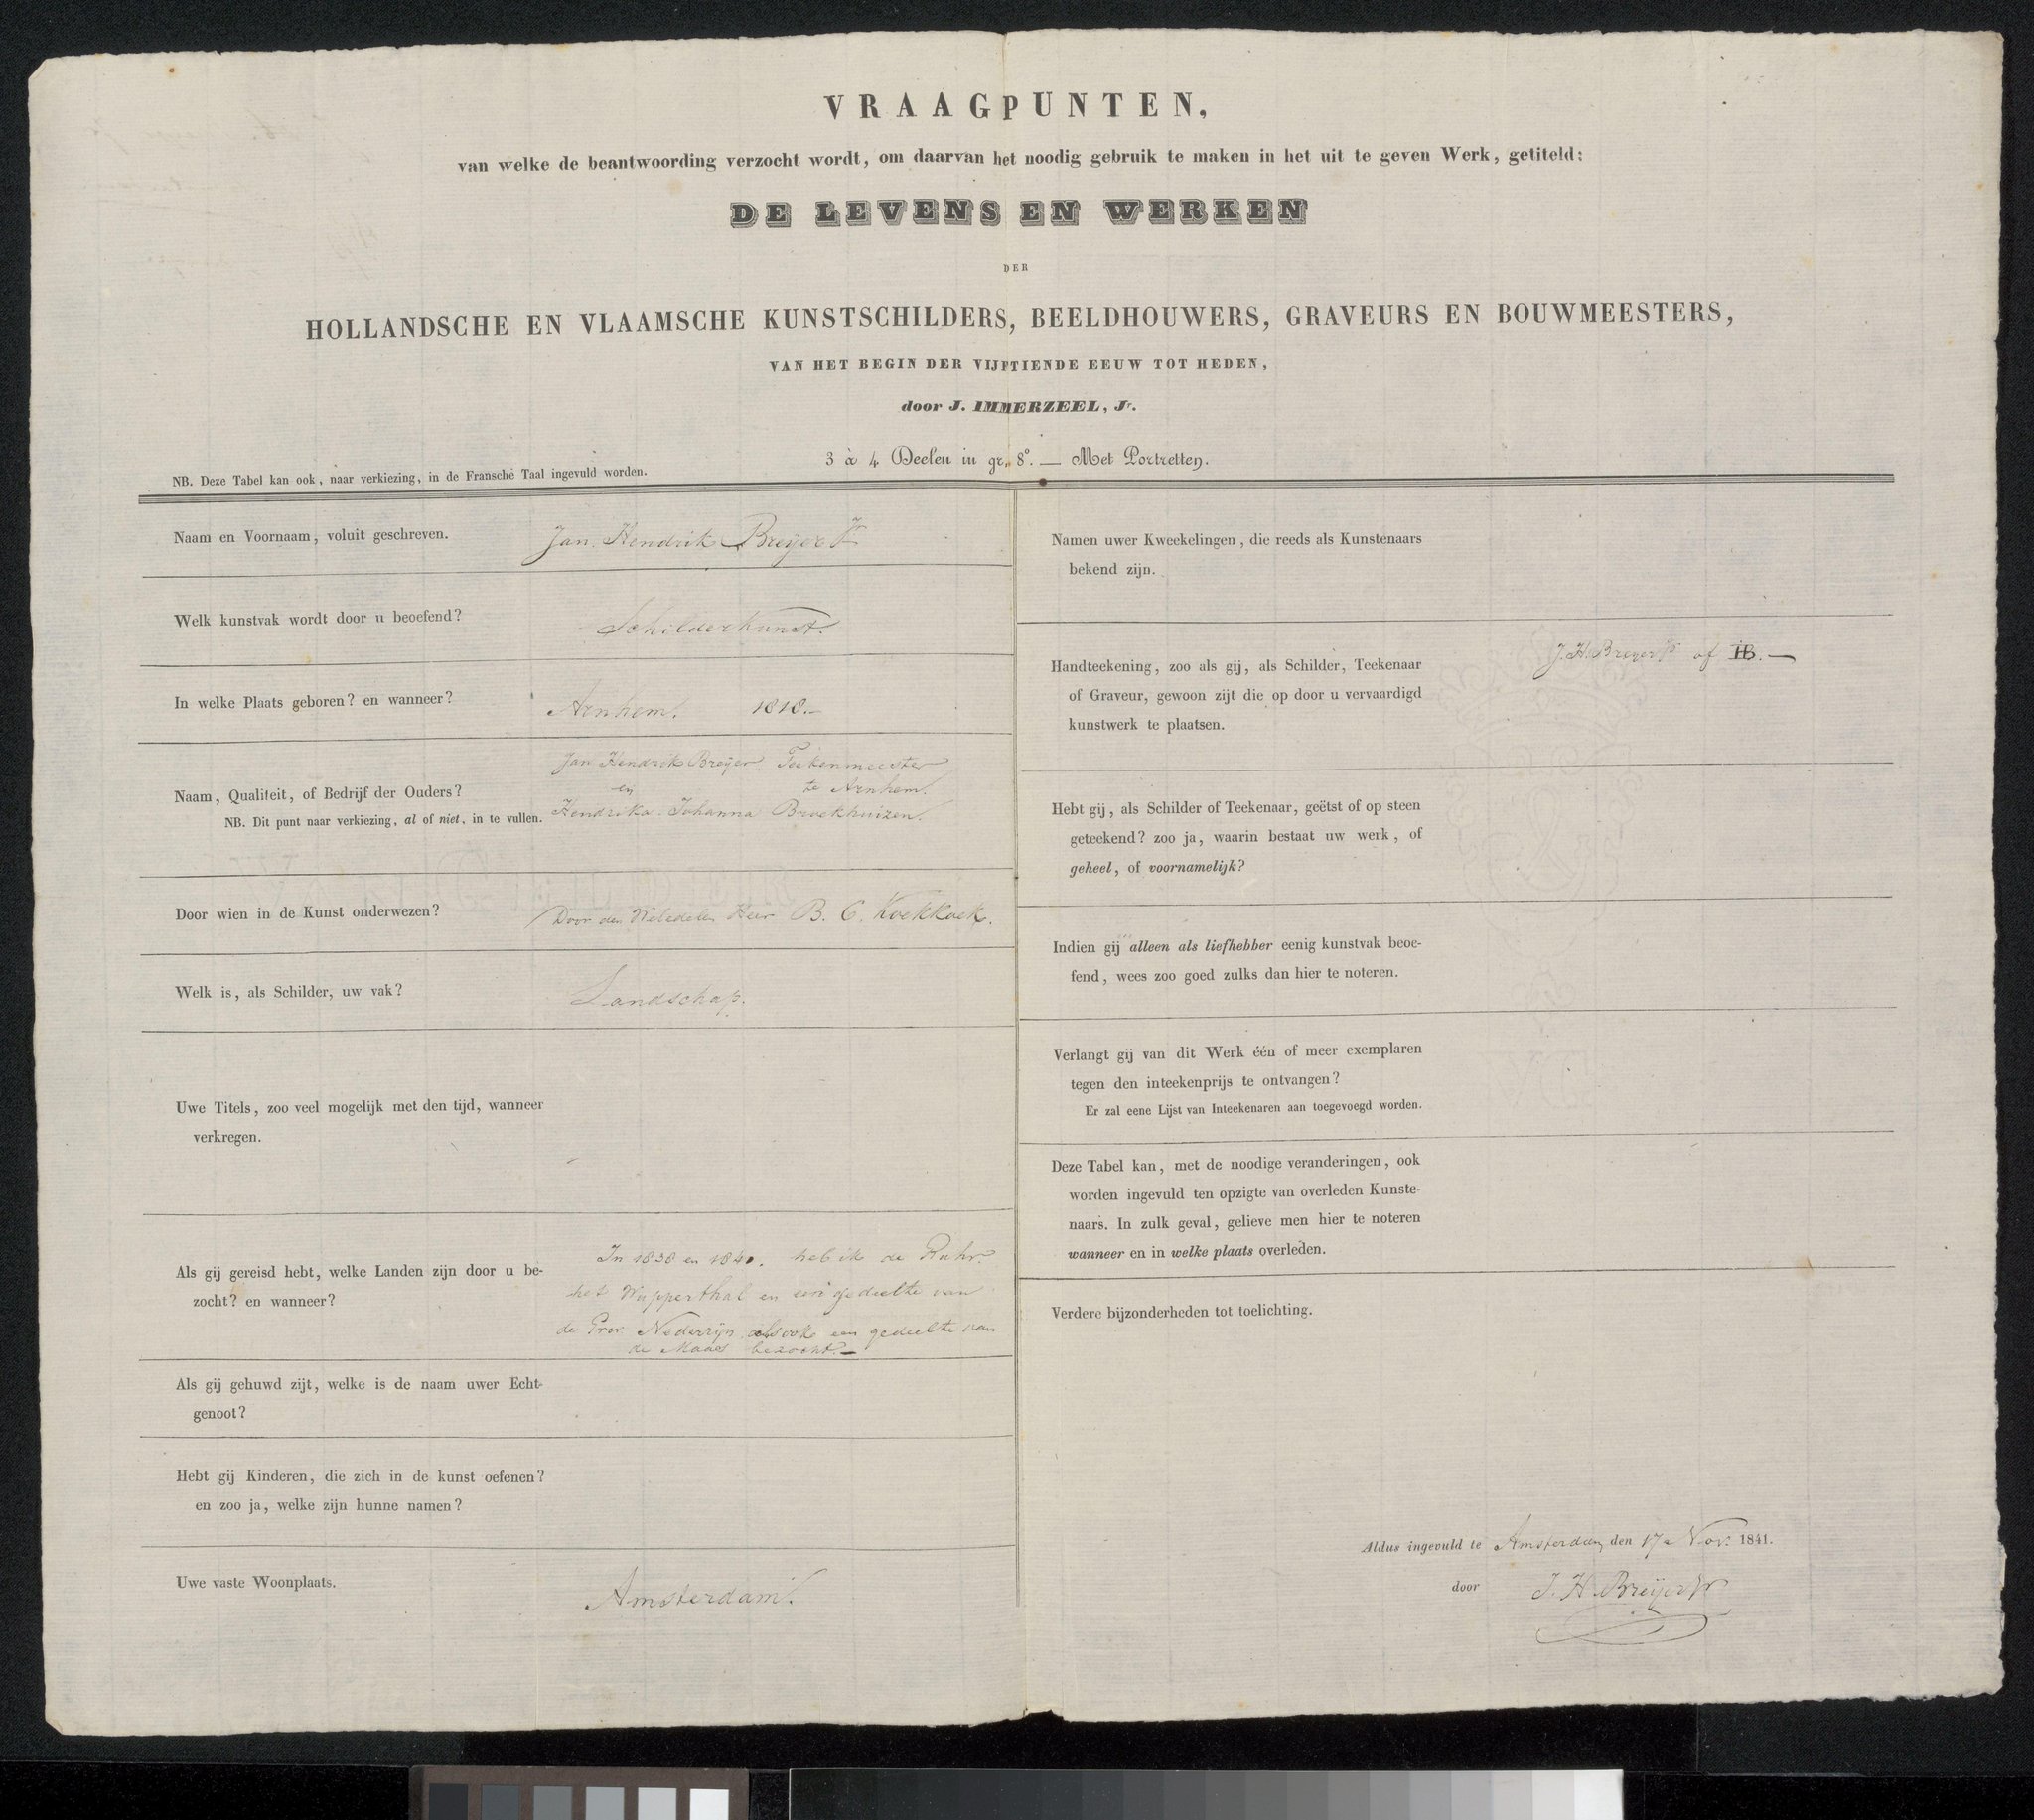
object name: manuscript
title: Enquêteformulier ingevuld door Jan Hendrik Breijer (II)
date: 1840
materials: ink, paper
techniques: pen, printing, writing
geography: amsterdam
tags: arnhem, draughtsman, jan hendrik breijer (ii)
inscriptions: inscription: ‘Vraagpunten,/ van welke de beantwoording verzocht wordt, om daarvan het noodig gebruik te maken in het uit te geven Werk, getiteld: De levens en werken/ der Hollandsche en Vlaamsche kunstschilders, beeldhouwers,/ graveurs en bouwmeesters, van het begin der vijftiende eeuw tot heden/ door J. Immerzeel, Jr.’, watermark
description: Opgenomen in: Immerzeel, J. Jr., De levens en werken der Hollandsche en Vlaamsche kunstschilders, beeldhouwers, graveurs en bouwmeesters, van het begin der vijftiende eeuw tot heden, Amsterdam: J.C. van Kesteren, 1842-1843.